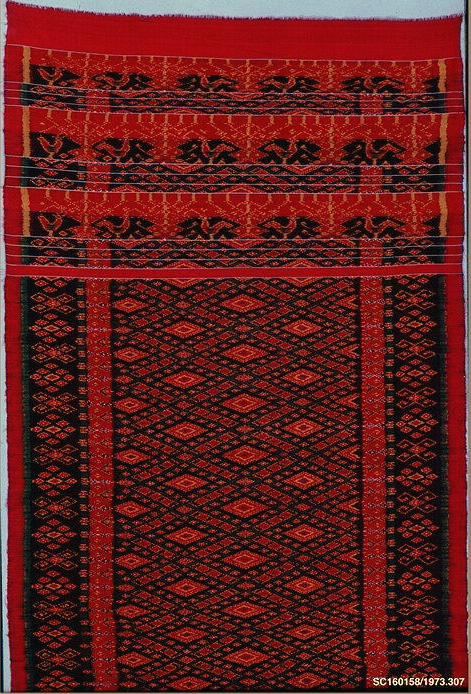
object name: skirt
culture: cambodian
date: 1801-1933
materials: silk